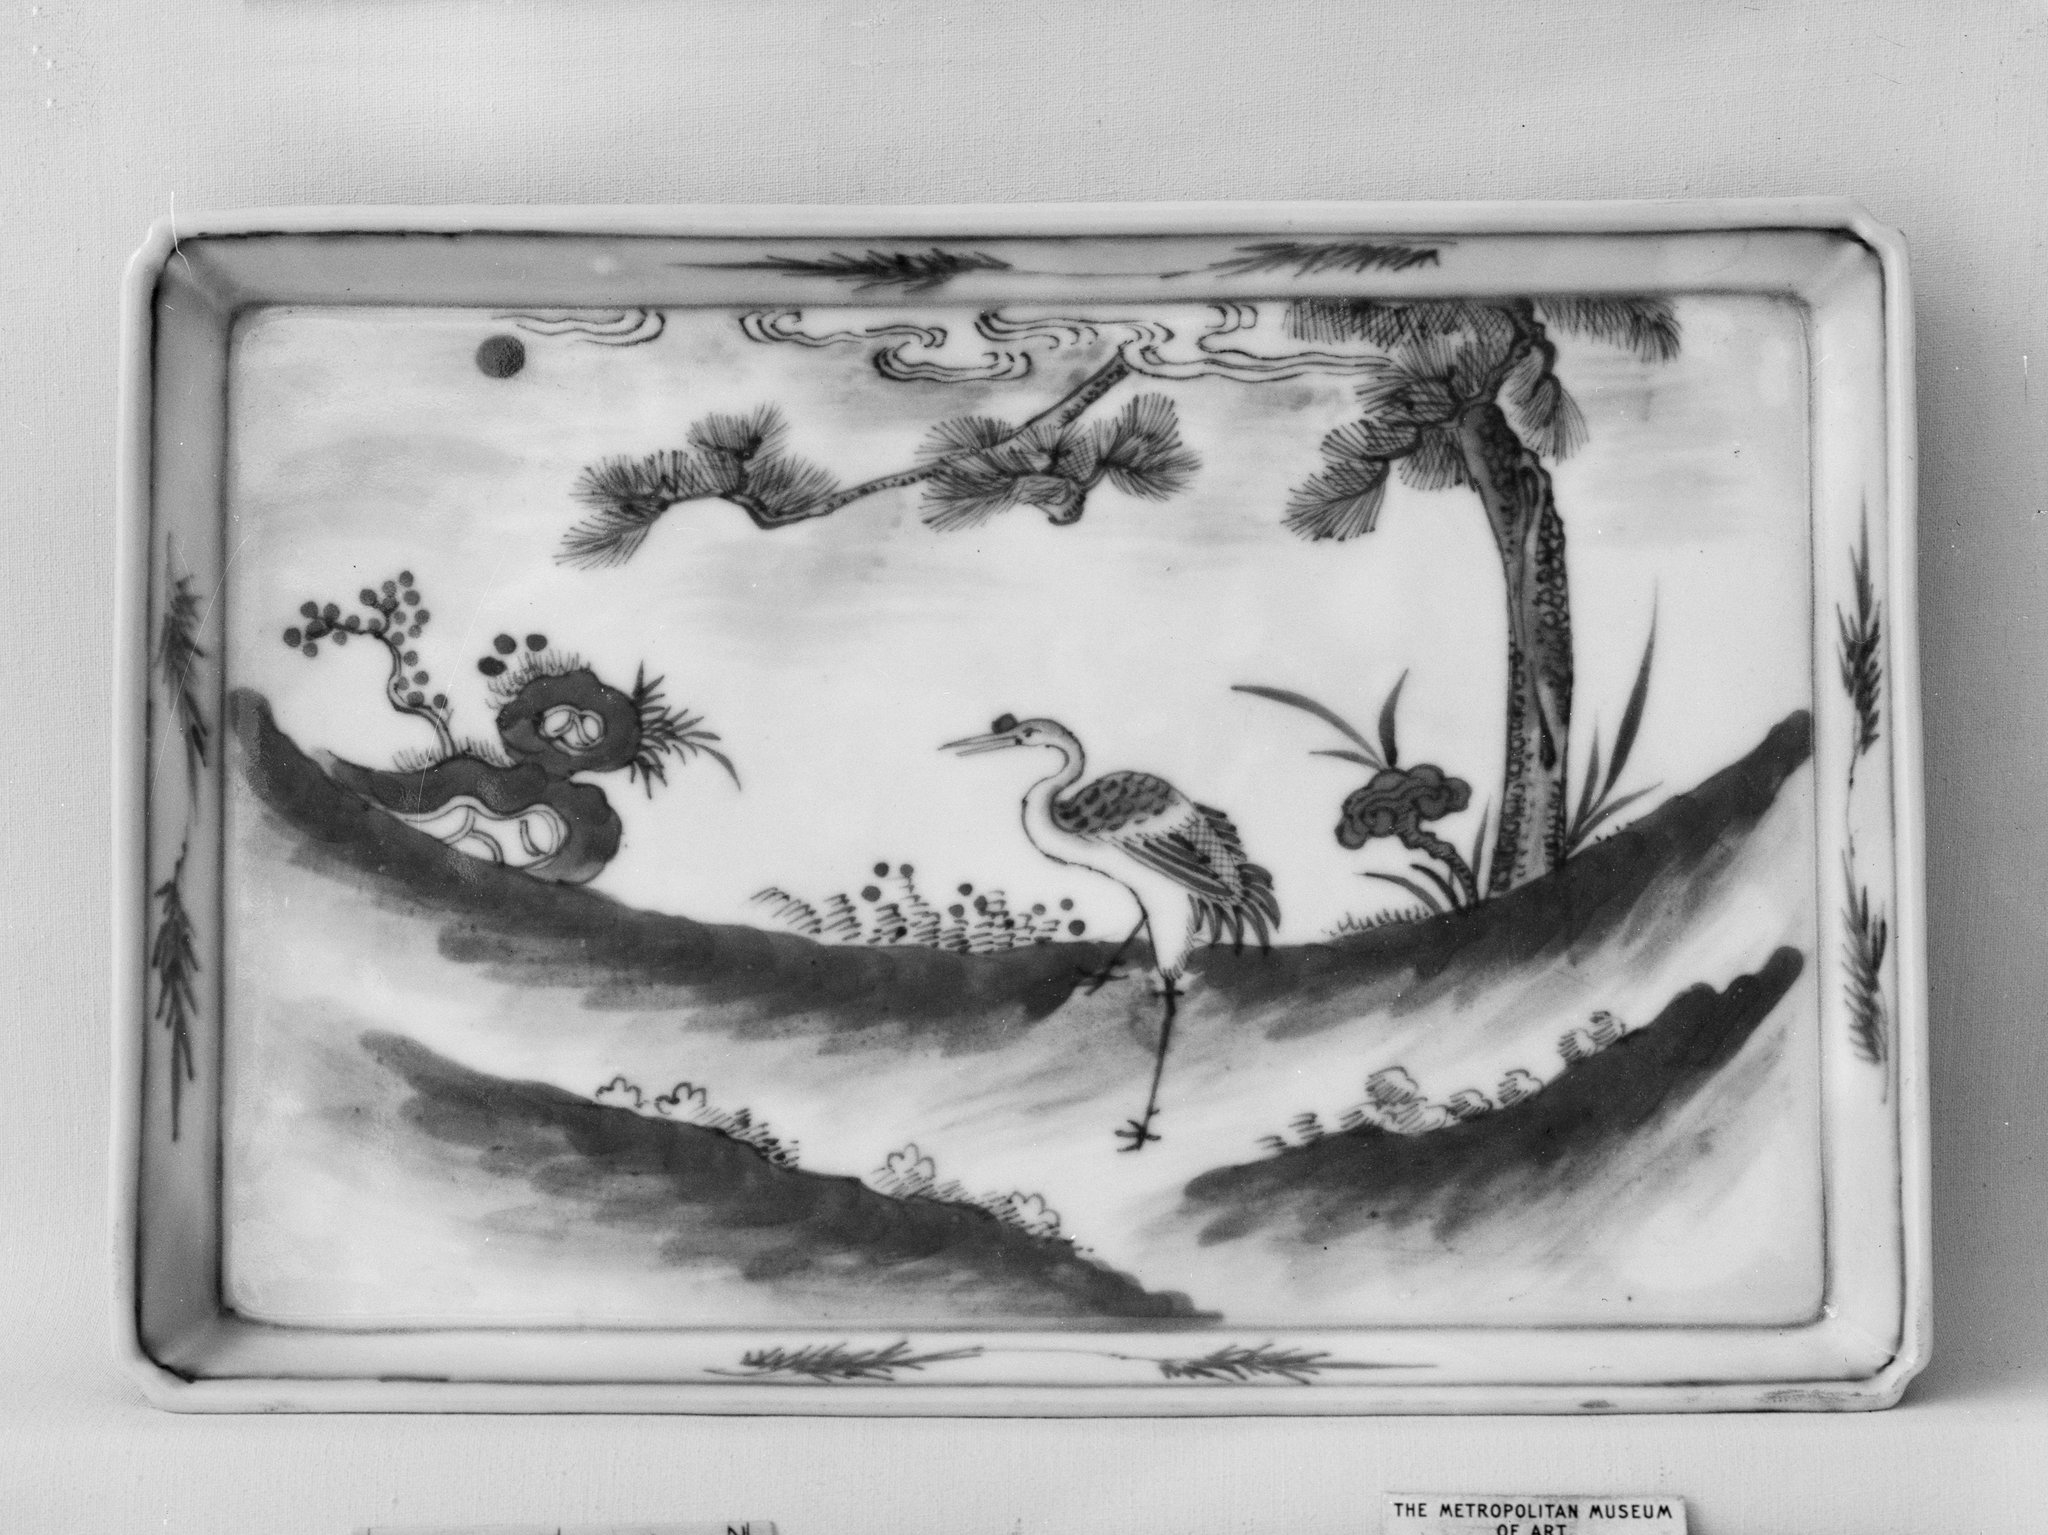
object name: tray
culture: japanese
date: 1801-1900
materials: porcelain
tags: cranes,trees